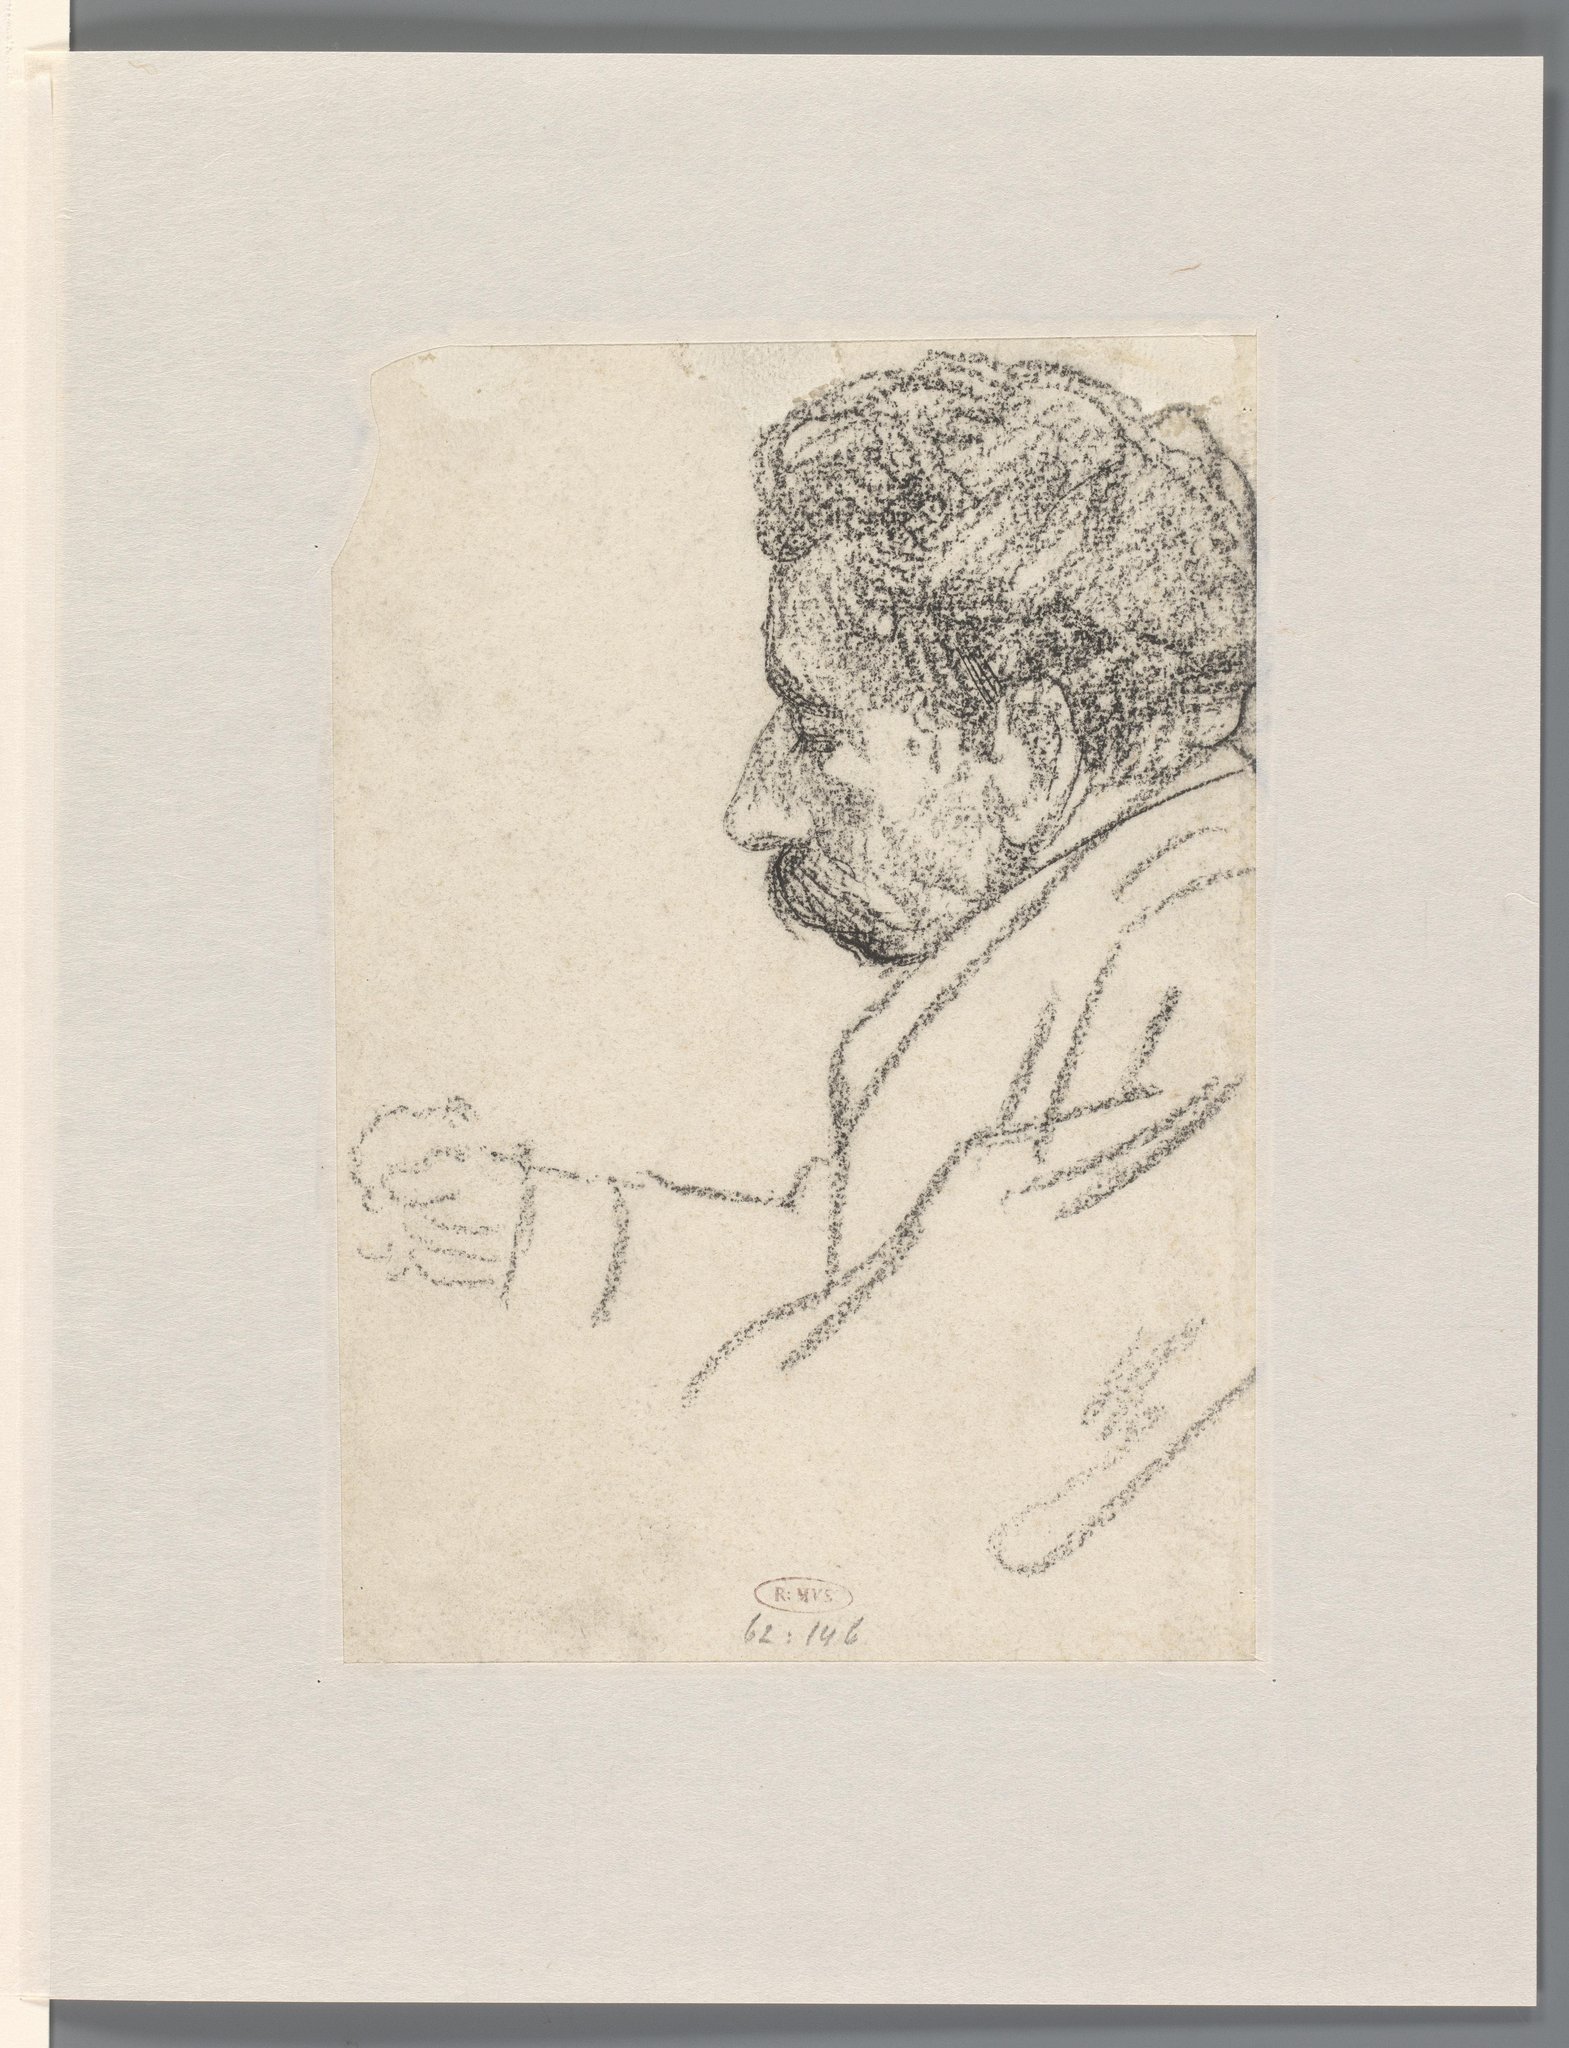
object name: drawing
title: Portret van een man met een snor, profiel naar links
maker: jan veth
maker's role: designer, draughtsman, painter, print maker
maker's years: 1864-1925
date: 1874-1925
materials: chalk, paper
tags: anonymous historical person portrayed alone